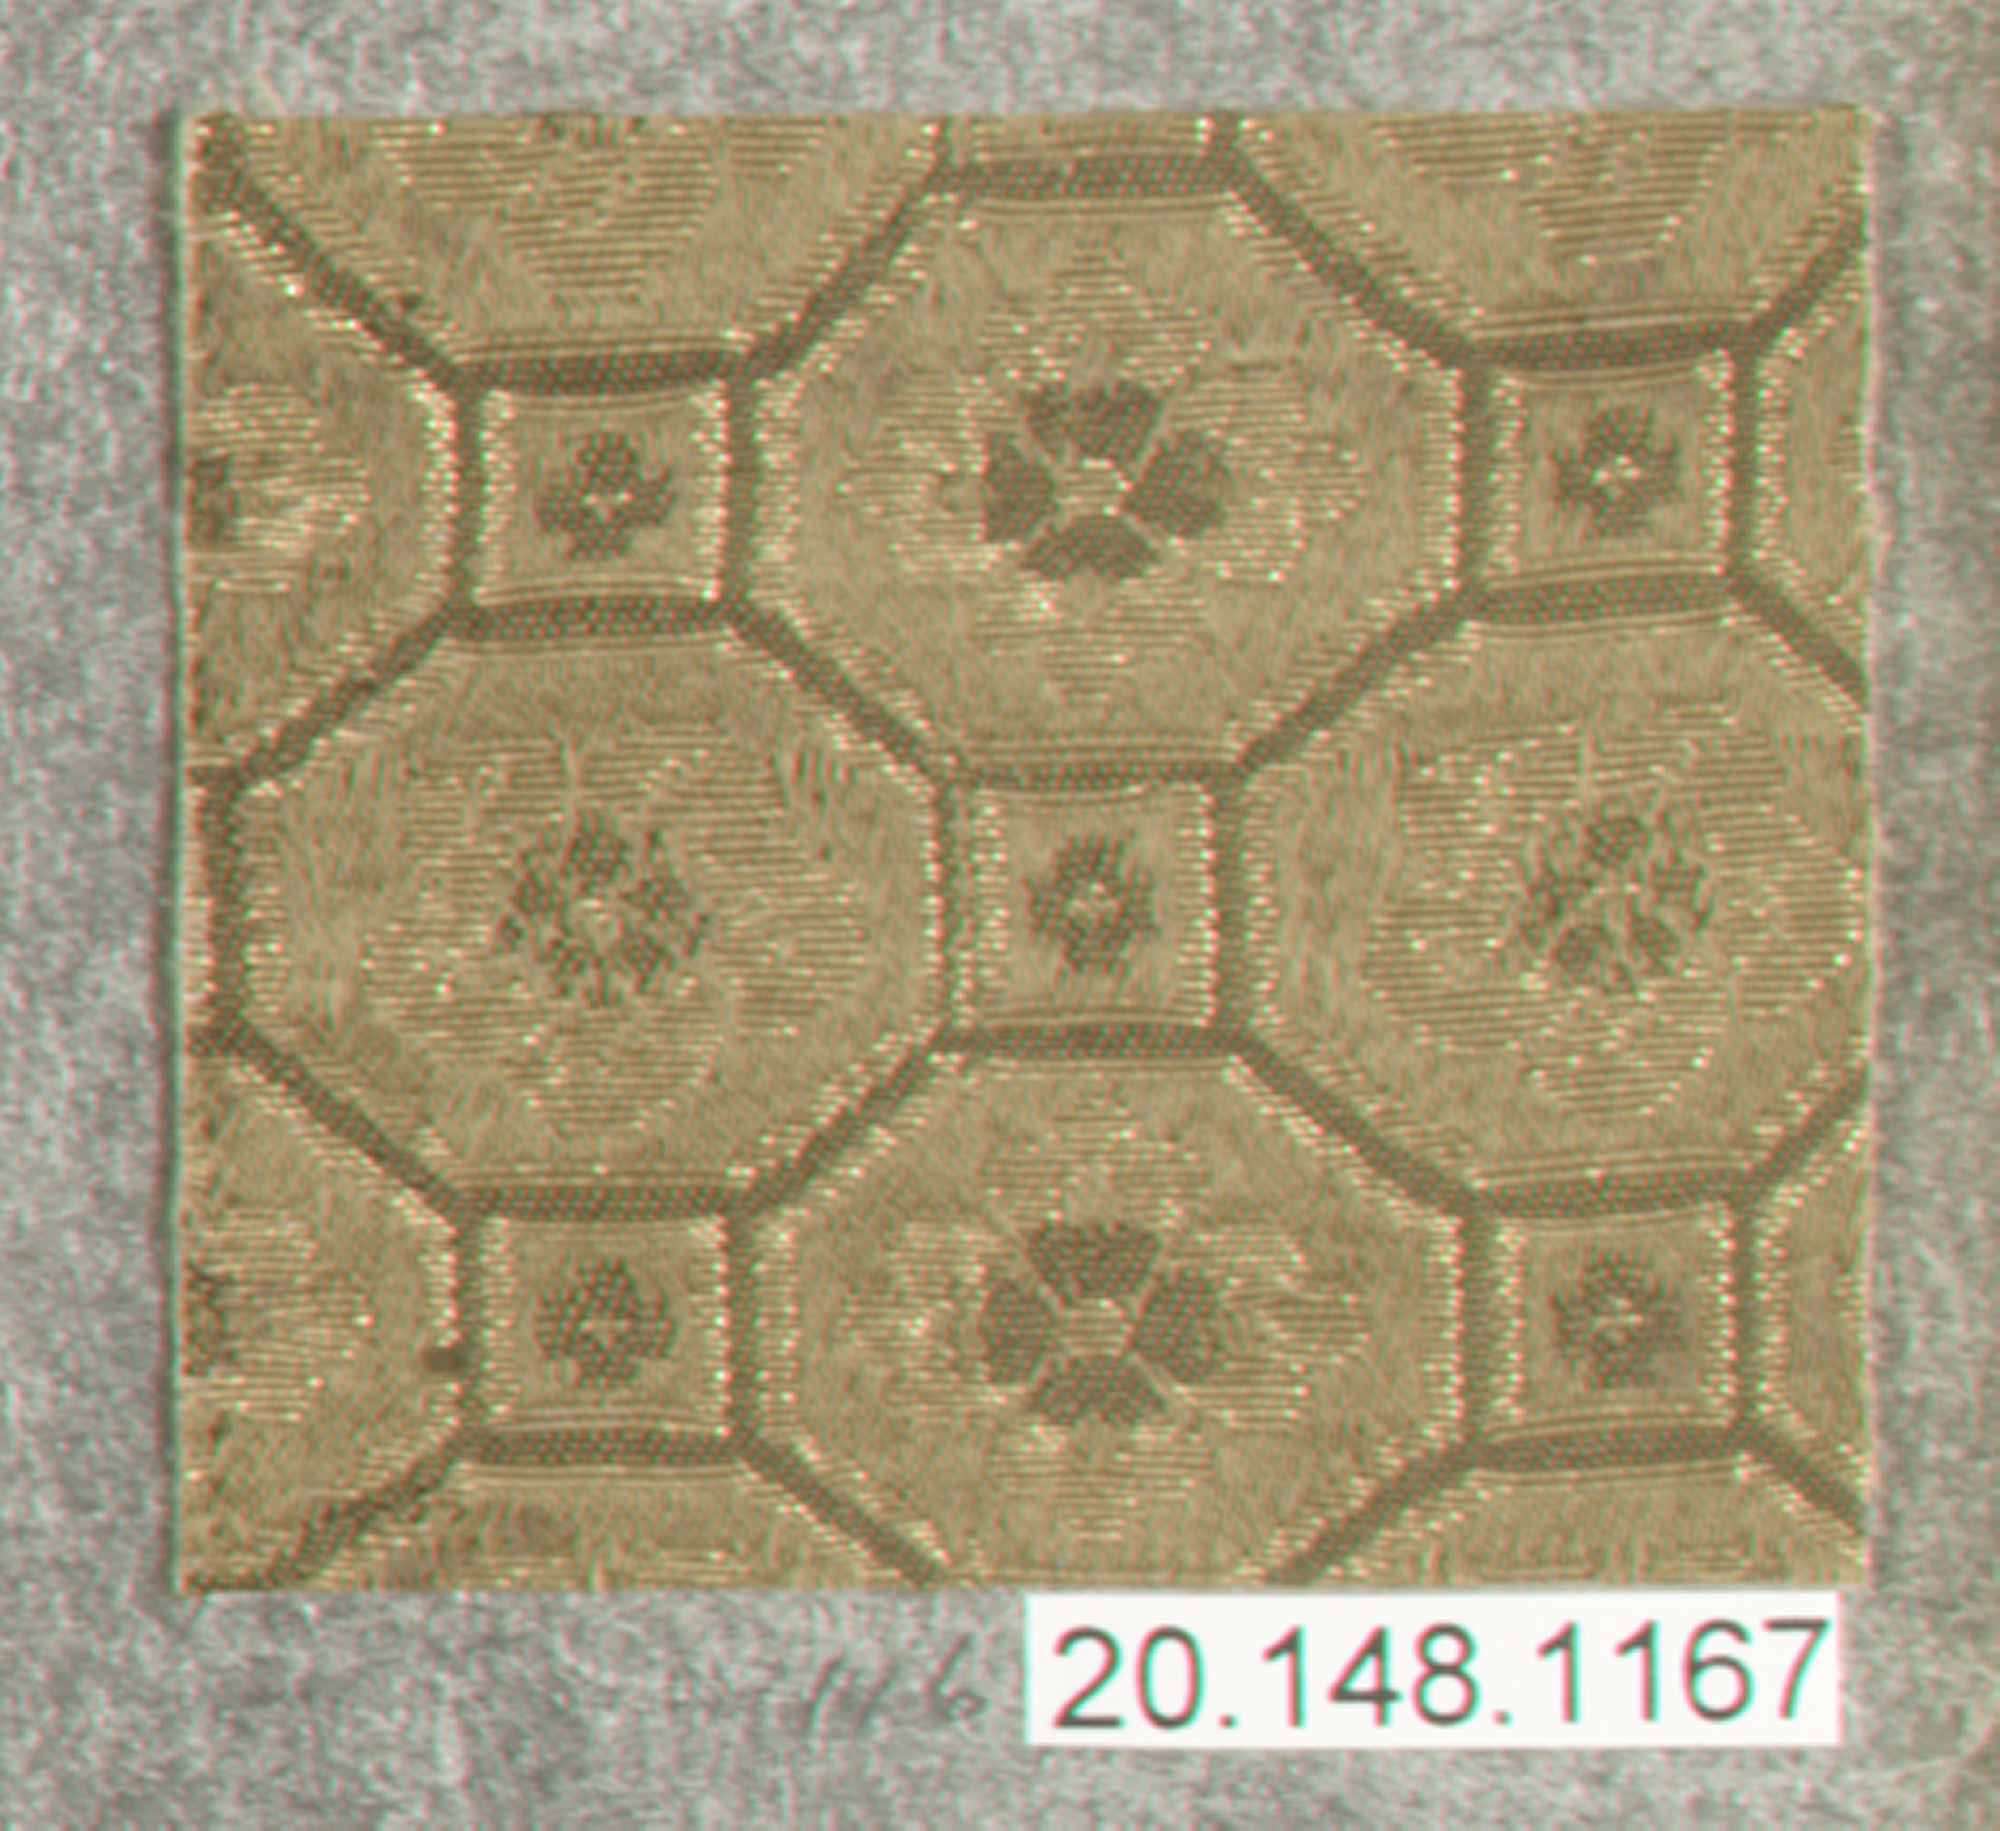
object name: piece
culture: japanese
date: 1801-1900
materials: silk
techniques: compound weave